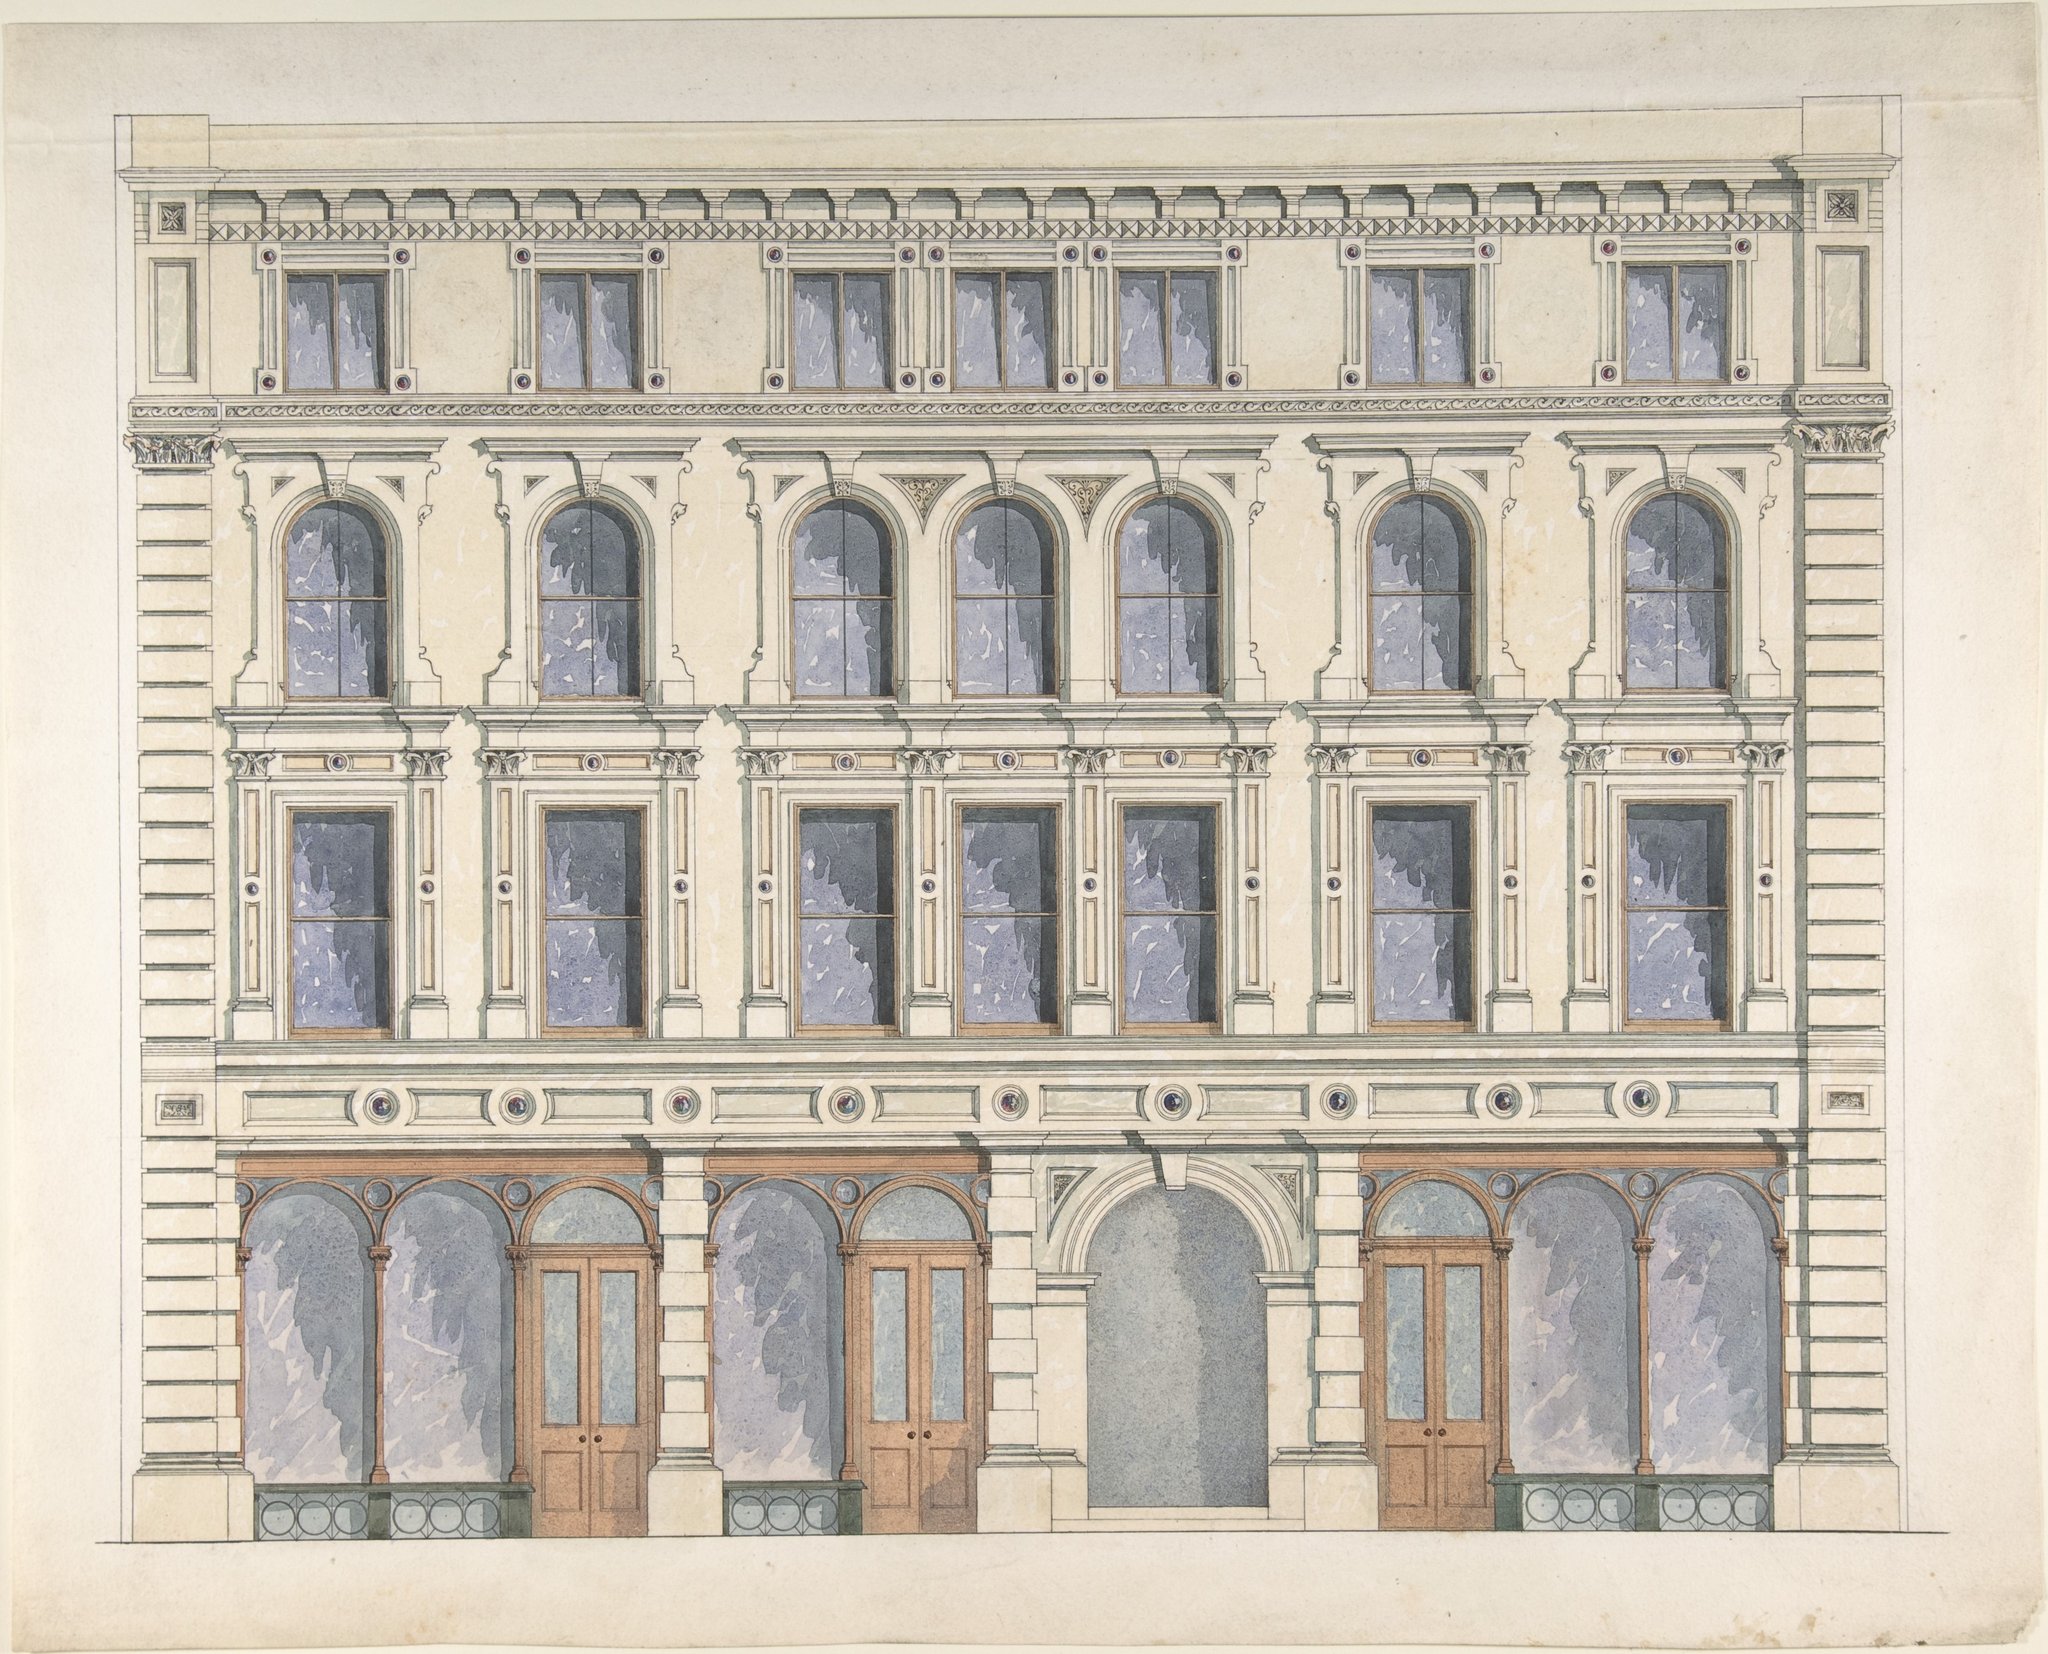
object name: drawing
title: Design for a City Building with Three Shops on the Ground Floor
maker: anonymous, british, 19th century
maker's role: artist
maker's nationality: british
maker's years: 1800-1900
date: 1801-1900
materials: ink, watercolor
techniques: brush, pen, wash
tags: buildings